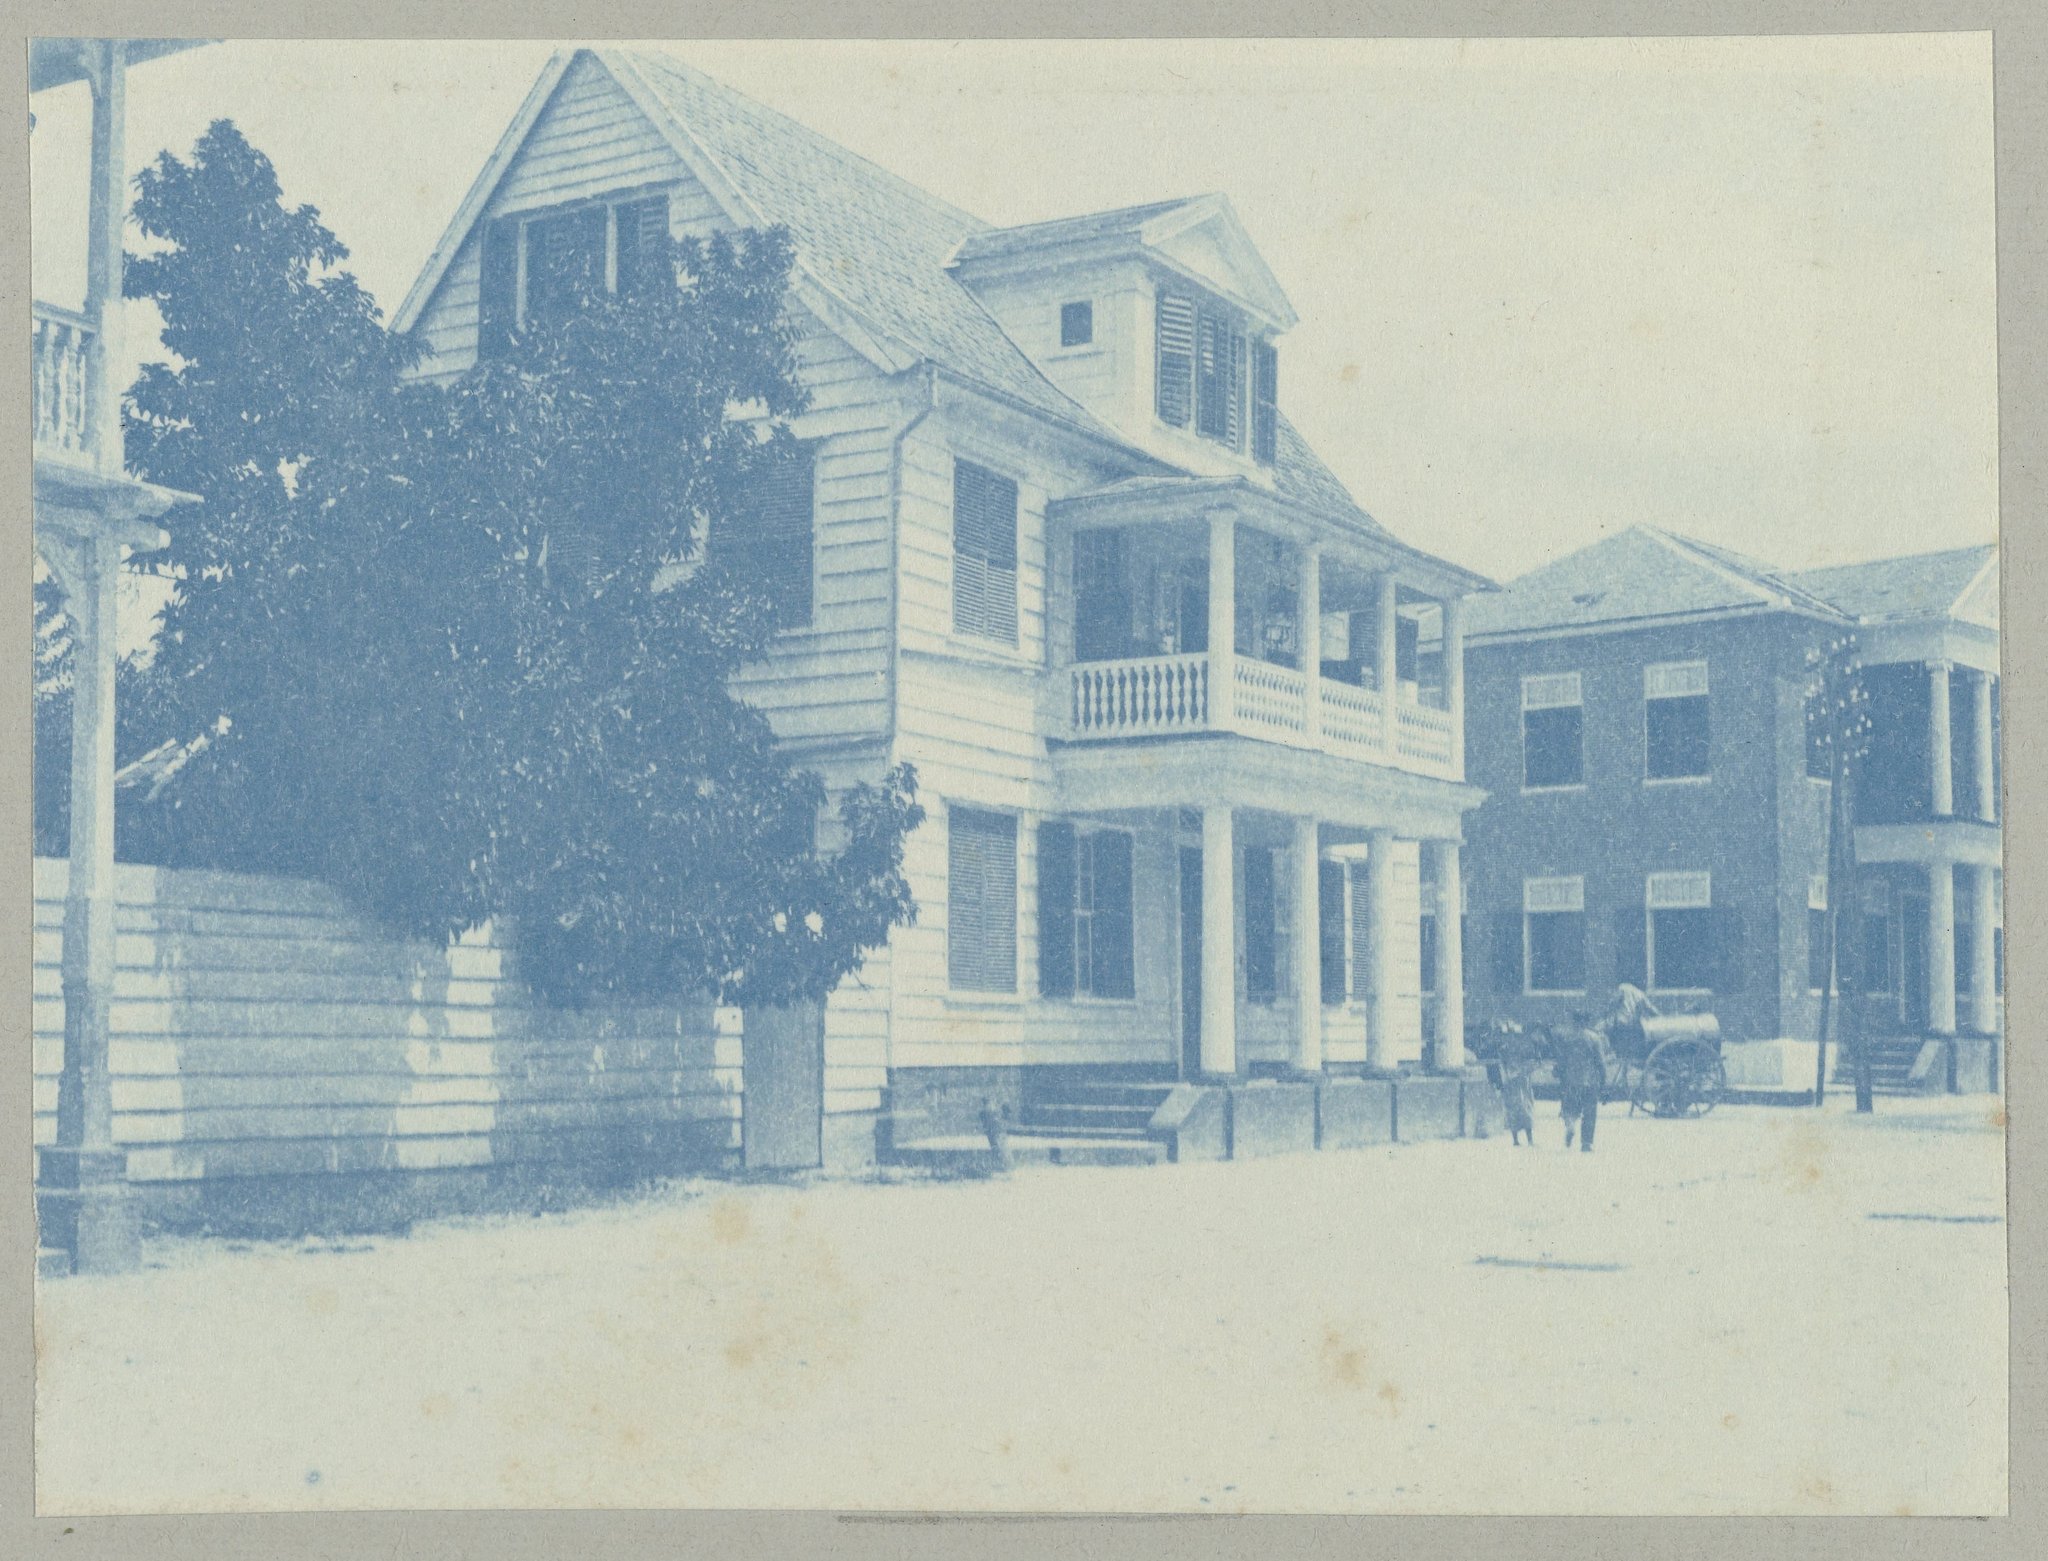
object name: photograph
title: Ons huis in de Oranjestraat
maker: hendrik doijer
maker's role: engineer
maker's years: 1863-1925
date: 1903-1910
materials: photographic support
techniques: cyanotype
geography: suriname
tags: suriname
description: Woonhuis (van de familie Doijer?) in de Oranjestraat te Paramaribo. Onderdeel van het fotoalbum Souvenir de Voyage (deel 2), over het leven van de familie Doijer in en rond de plantage Ma Retraite in Suriname in de jaren 1903-1910.